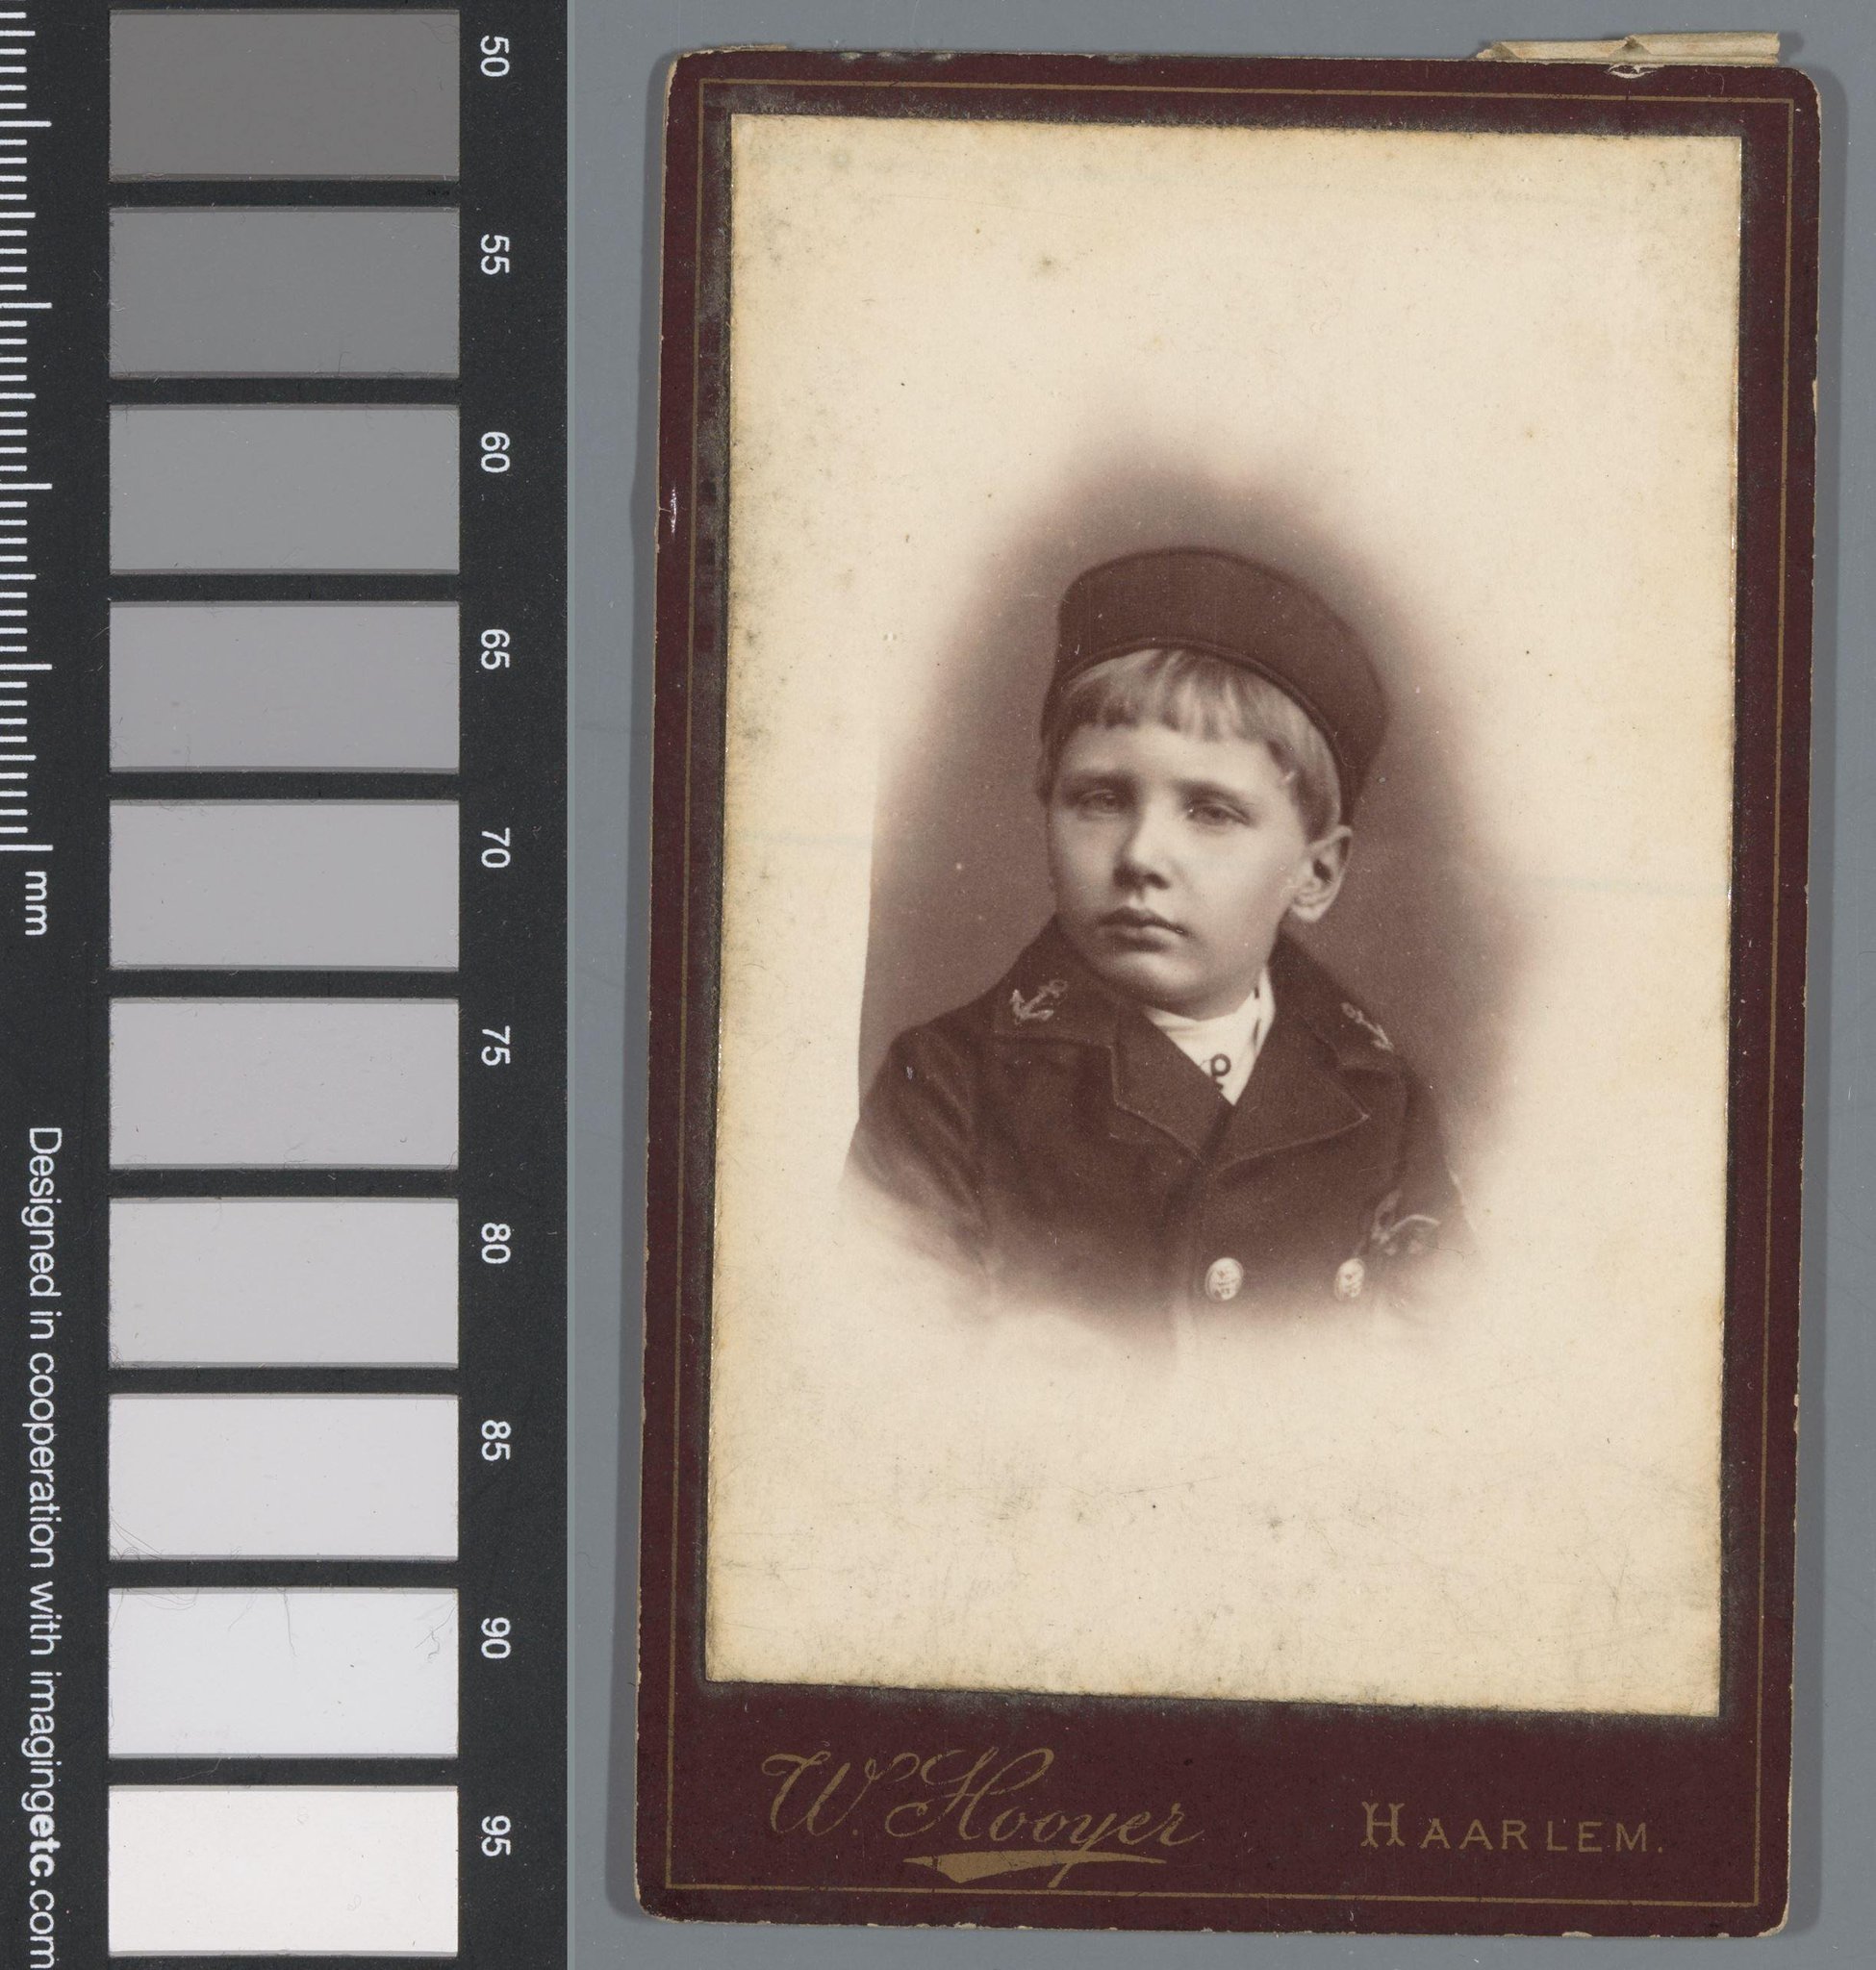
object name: carte de visite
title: Portret van een onbekende jongen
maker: willem hooijer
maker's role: fotograaf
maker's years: 1855-1939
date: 1892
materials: paper, cardboard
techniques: collodion silver print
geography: haarlem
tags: boy (child between toddler and youth), anonymous historical person portrayed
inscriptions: inscription: ‘SPECIALITEIT IN VERGROOTINGEN./ No.................’, address: ‘Parklaan 4/ by het Kenaupark/ Haarlem’